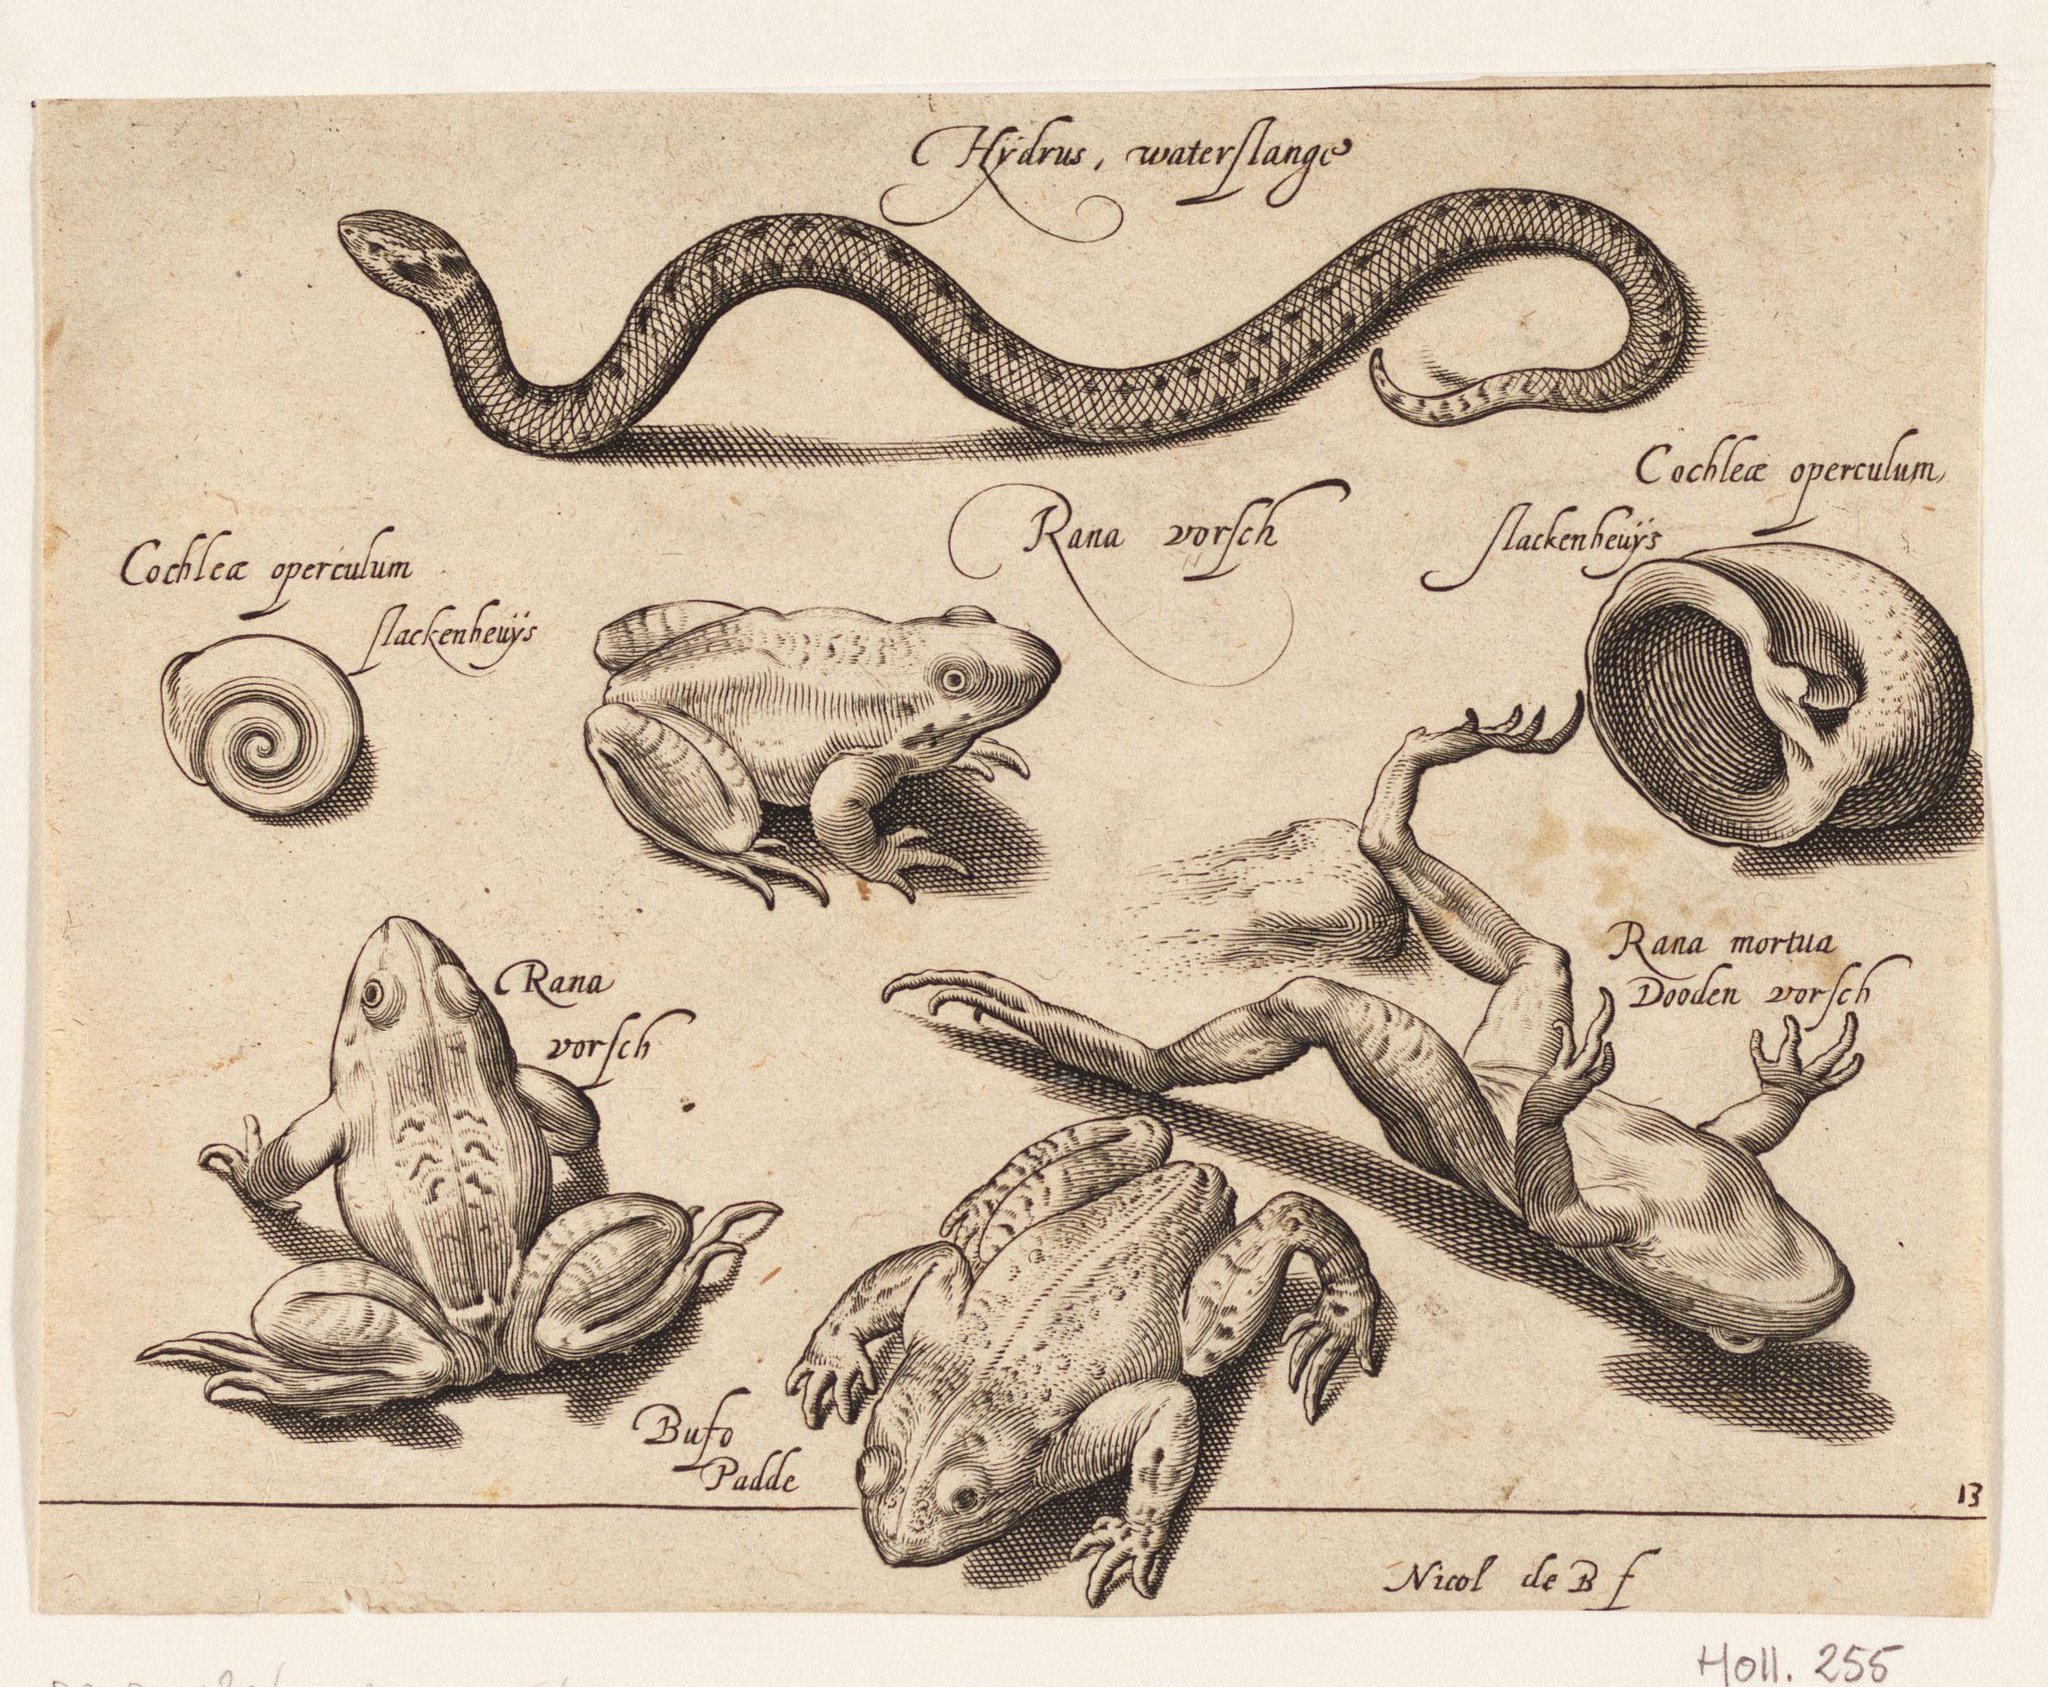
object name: print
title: Zoetwatervissen, zeevissen, kikkers, schaaldieren en zeewezens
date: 1581-1656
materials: paper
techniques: engraving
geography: netherlands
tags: tailless amphibians: frog, snakes, tailless amphibians: toad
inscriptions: collector's mark: Lugt 2228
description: Prent uit serie Libelivs varia Genera piscium complectens van dertien prenten met zoetwatervissen, zeevissen, kikkers, schaaldieren en zeewezens (inclusief titelprent). Vermoedelijk ging een uitgave van Assuerus van Londerseel vooraf aan deze editie van Francoys van Beusekom, zie De Groot 1988, p. 38.